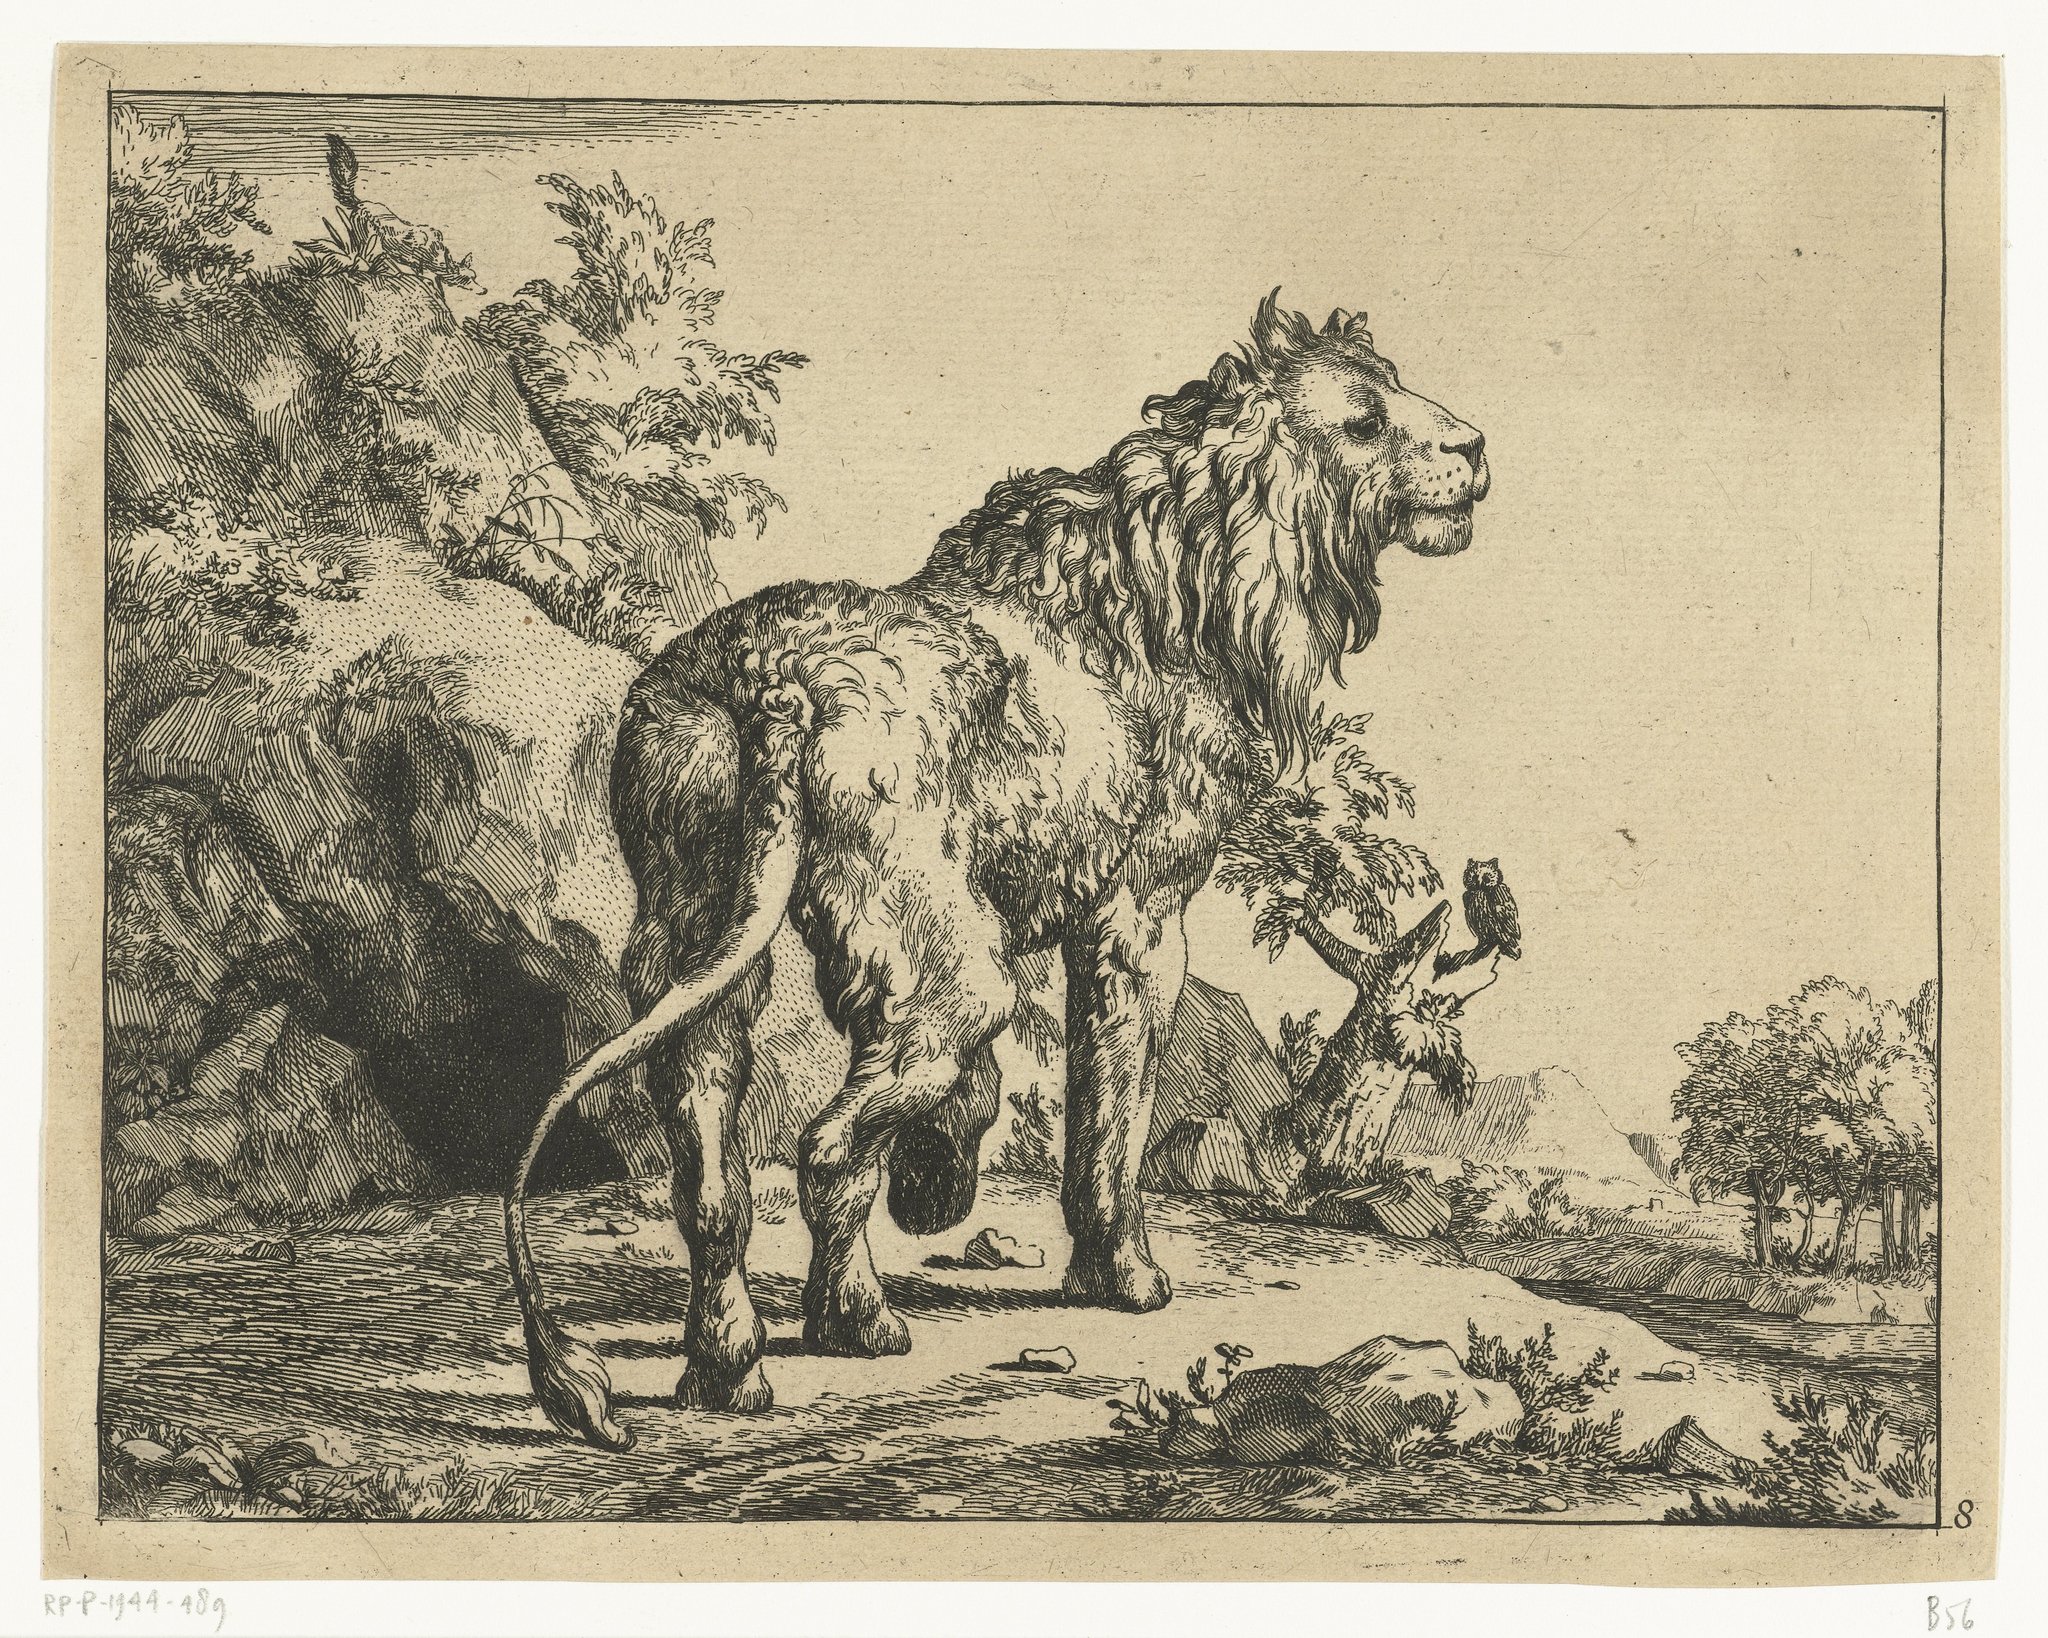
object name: print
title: Leeuwen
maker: marcus de bye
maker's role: print maker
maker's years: 1639-1688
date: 1664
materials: paper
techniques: etching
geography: the hague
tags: beasts of prey, predatory animals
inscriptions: collector's mark: Lugt 2228